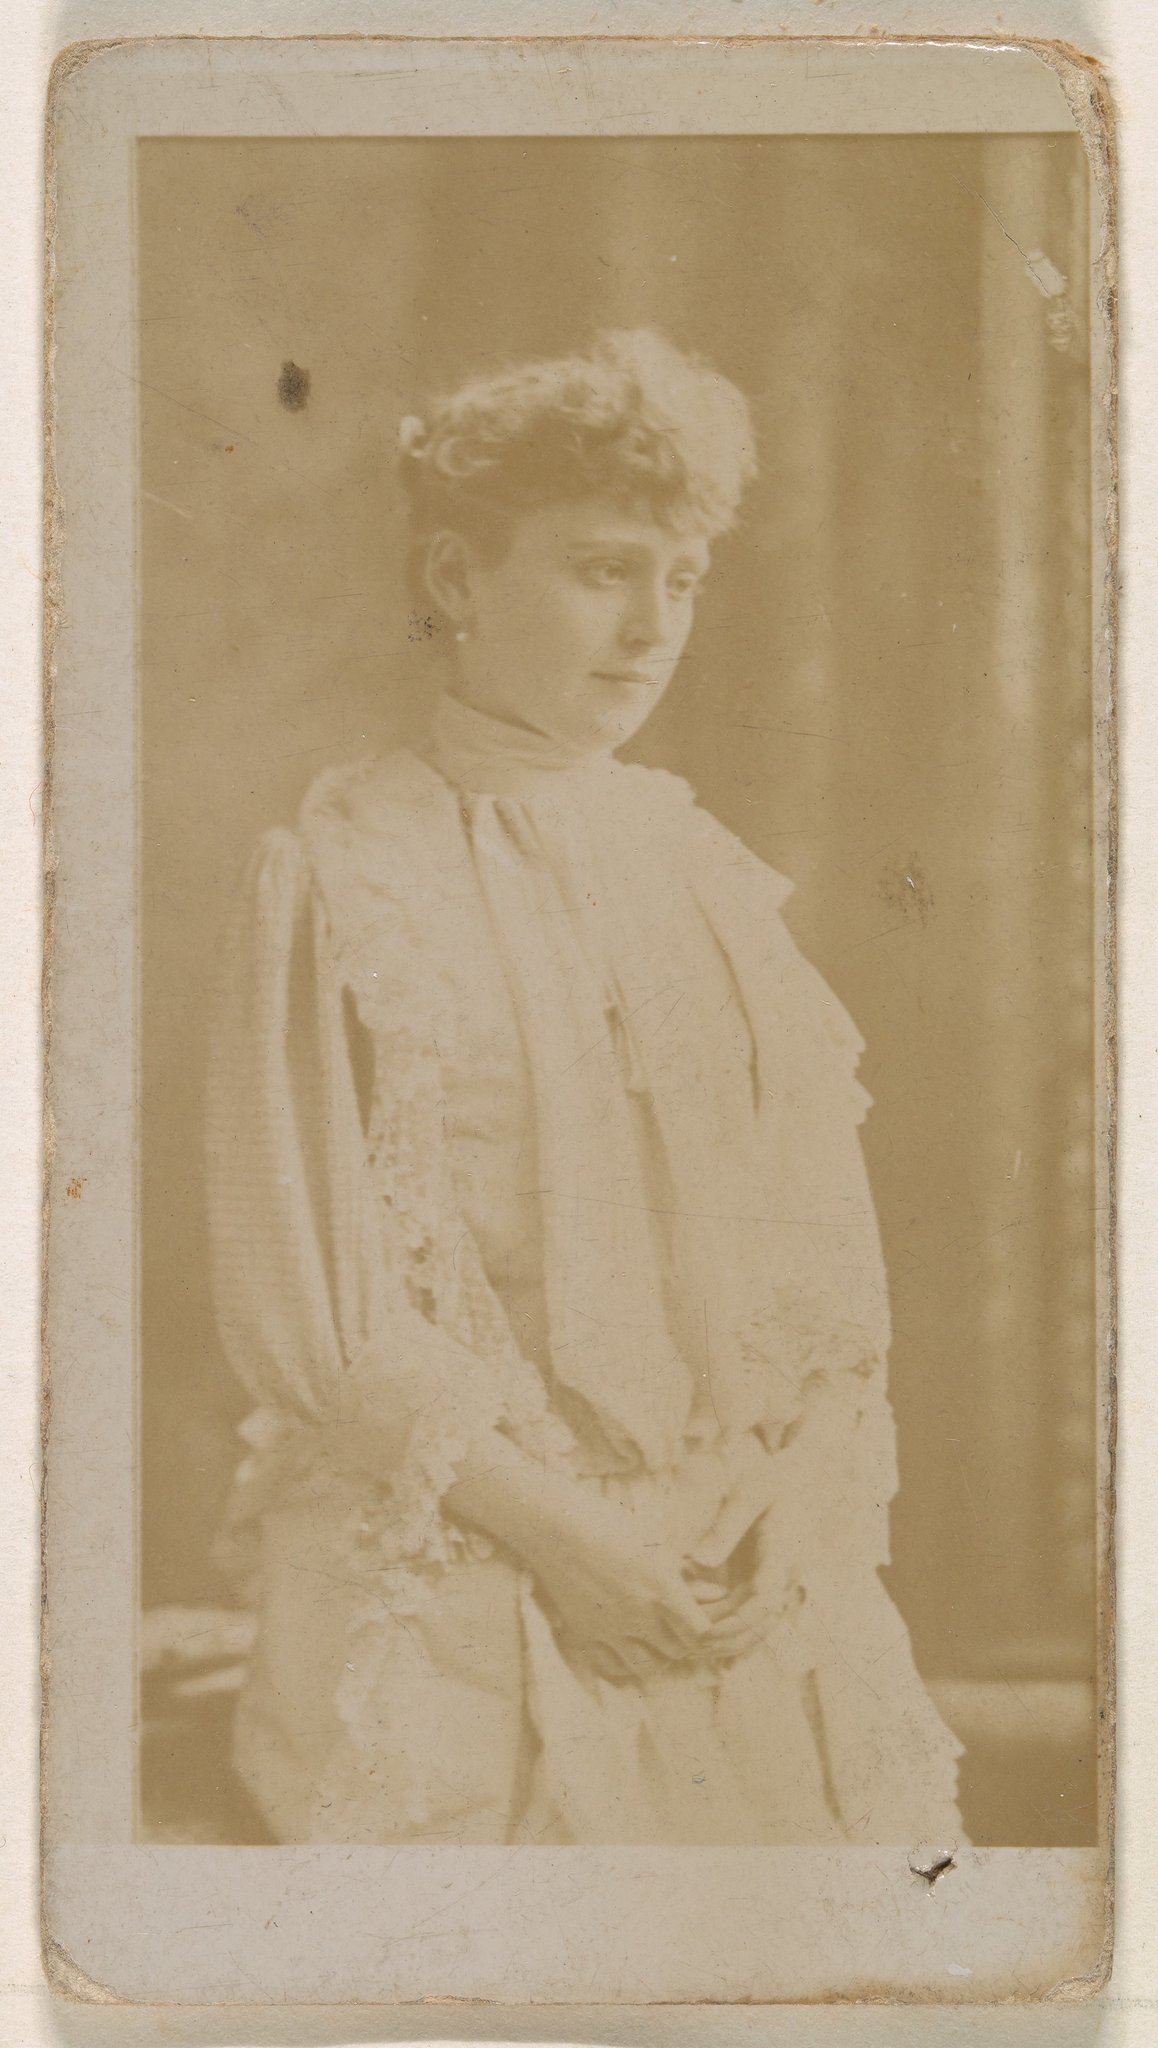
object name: photograph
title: Actress in profile dressed in white gown, from the Actresses series (N245) issued by Kinney Brothers to promote Sweet Caporal Cigarettes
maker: kinney brothers tobacco company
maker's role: publisher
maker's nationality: american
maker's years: 1869-2011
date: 1890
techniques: albumen silver print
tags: portraits,women,actresses